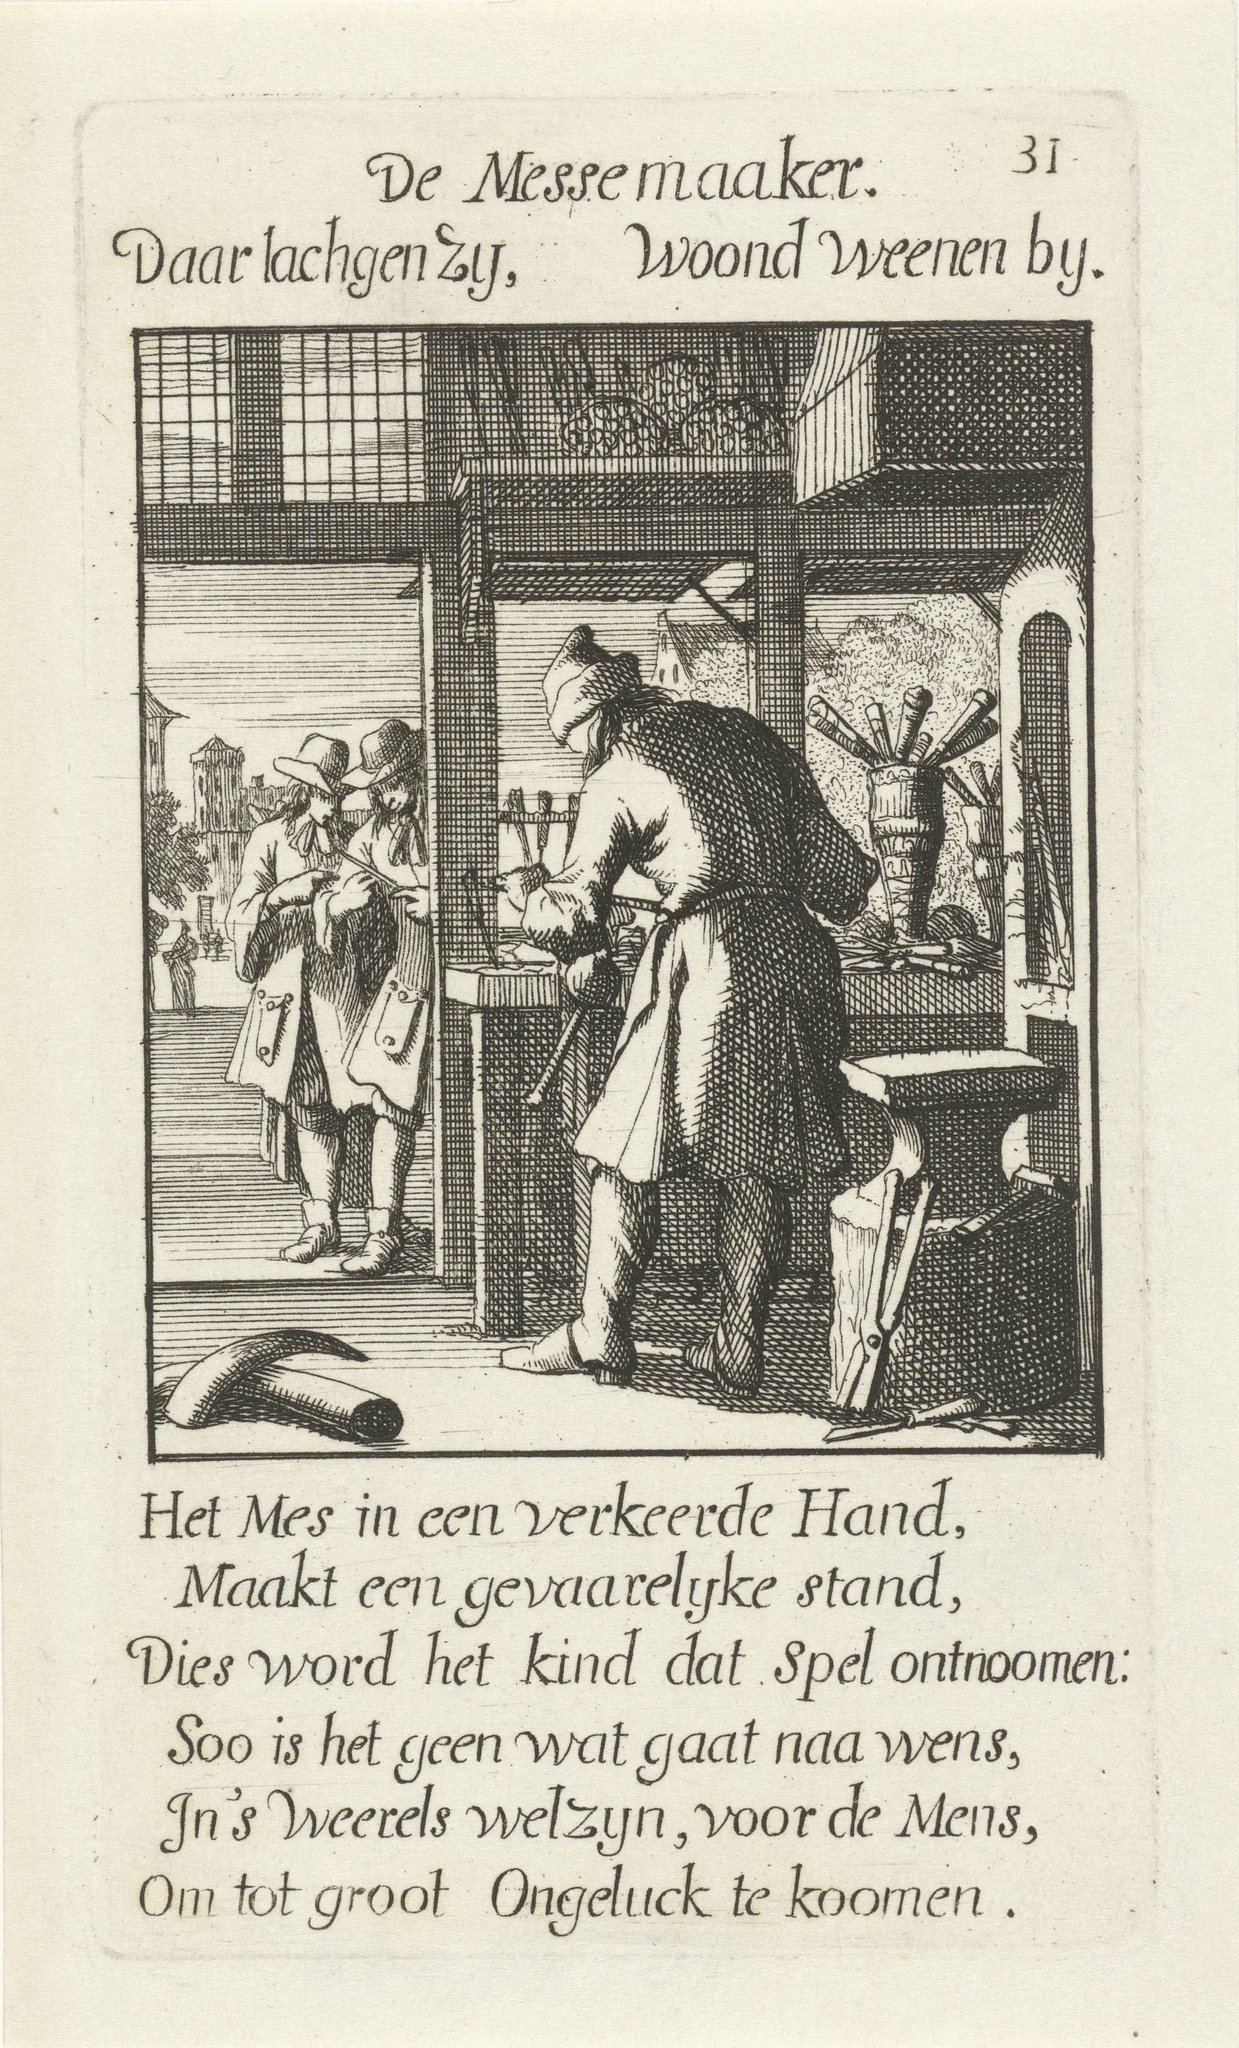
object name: print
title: De Messemaaker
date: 1694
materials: paper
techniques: etching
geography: amsterdam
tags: handicrafts, craftsman at work, tools, aids, implements ~ crafts and industries: knife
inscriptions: collector's mark: Lugt 2228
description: Maakt deel uit van de 100-delige serie beroepsprenten van Jan en Caspar Luyken, getiteld: Het menselyk bedryf. S.l.s.n., 1694 (eerste druk).